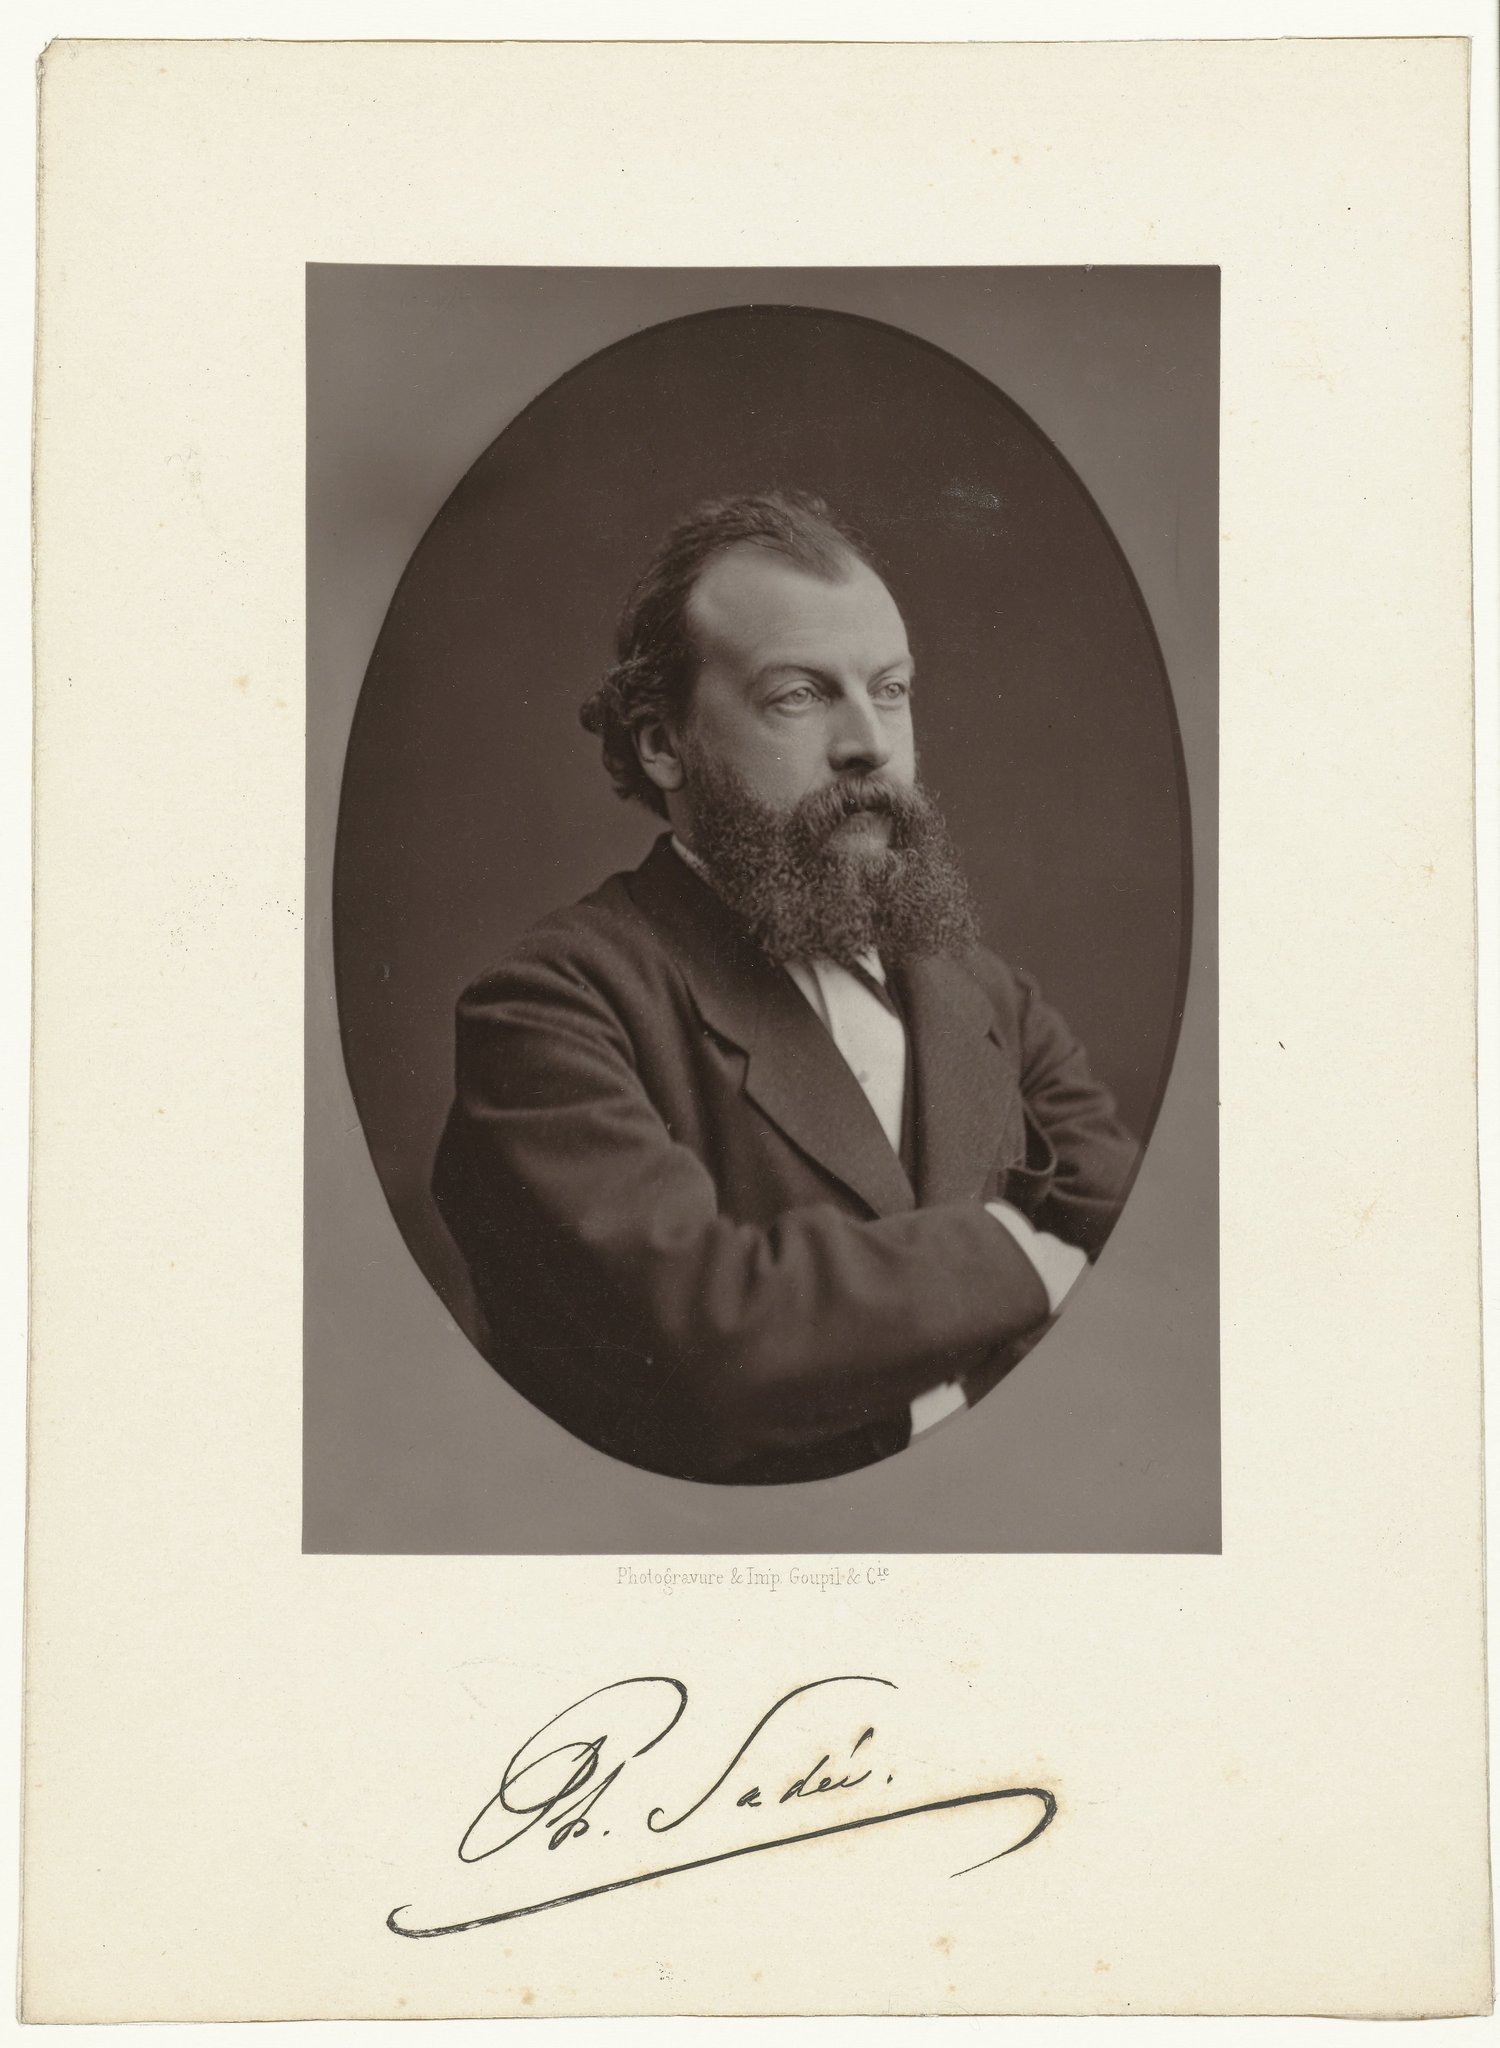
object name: photograph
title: Ph Sadée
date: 1881-1885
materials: cardboard, paper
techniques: woodburytype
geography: the hague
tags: the hague, painter, print maker, draughtsman, philip sadée, historical persons